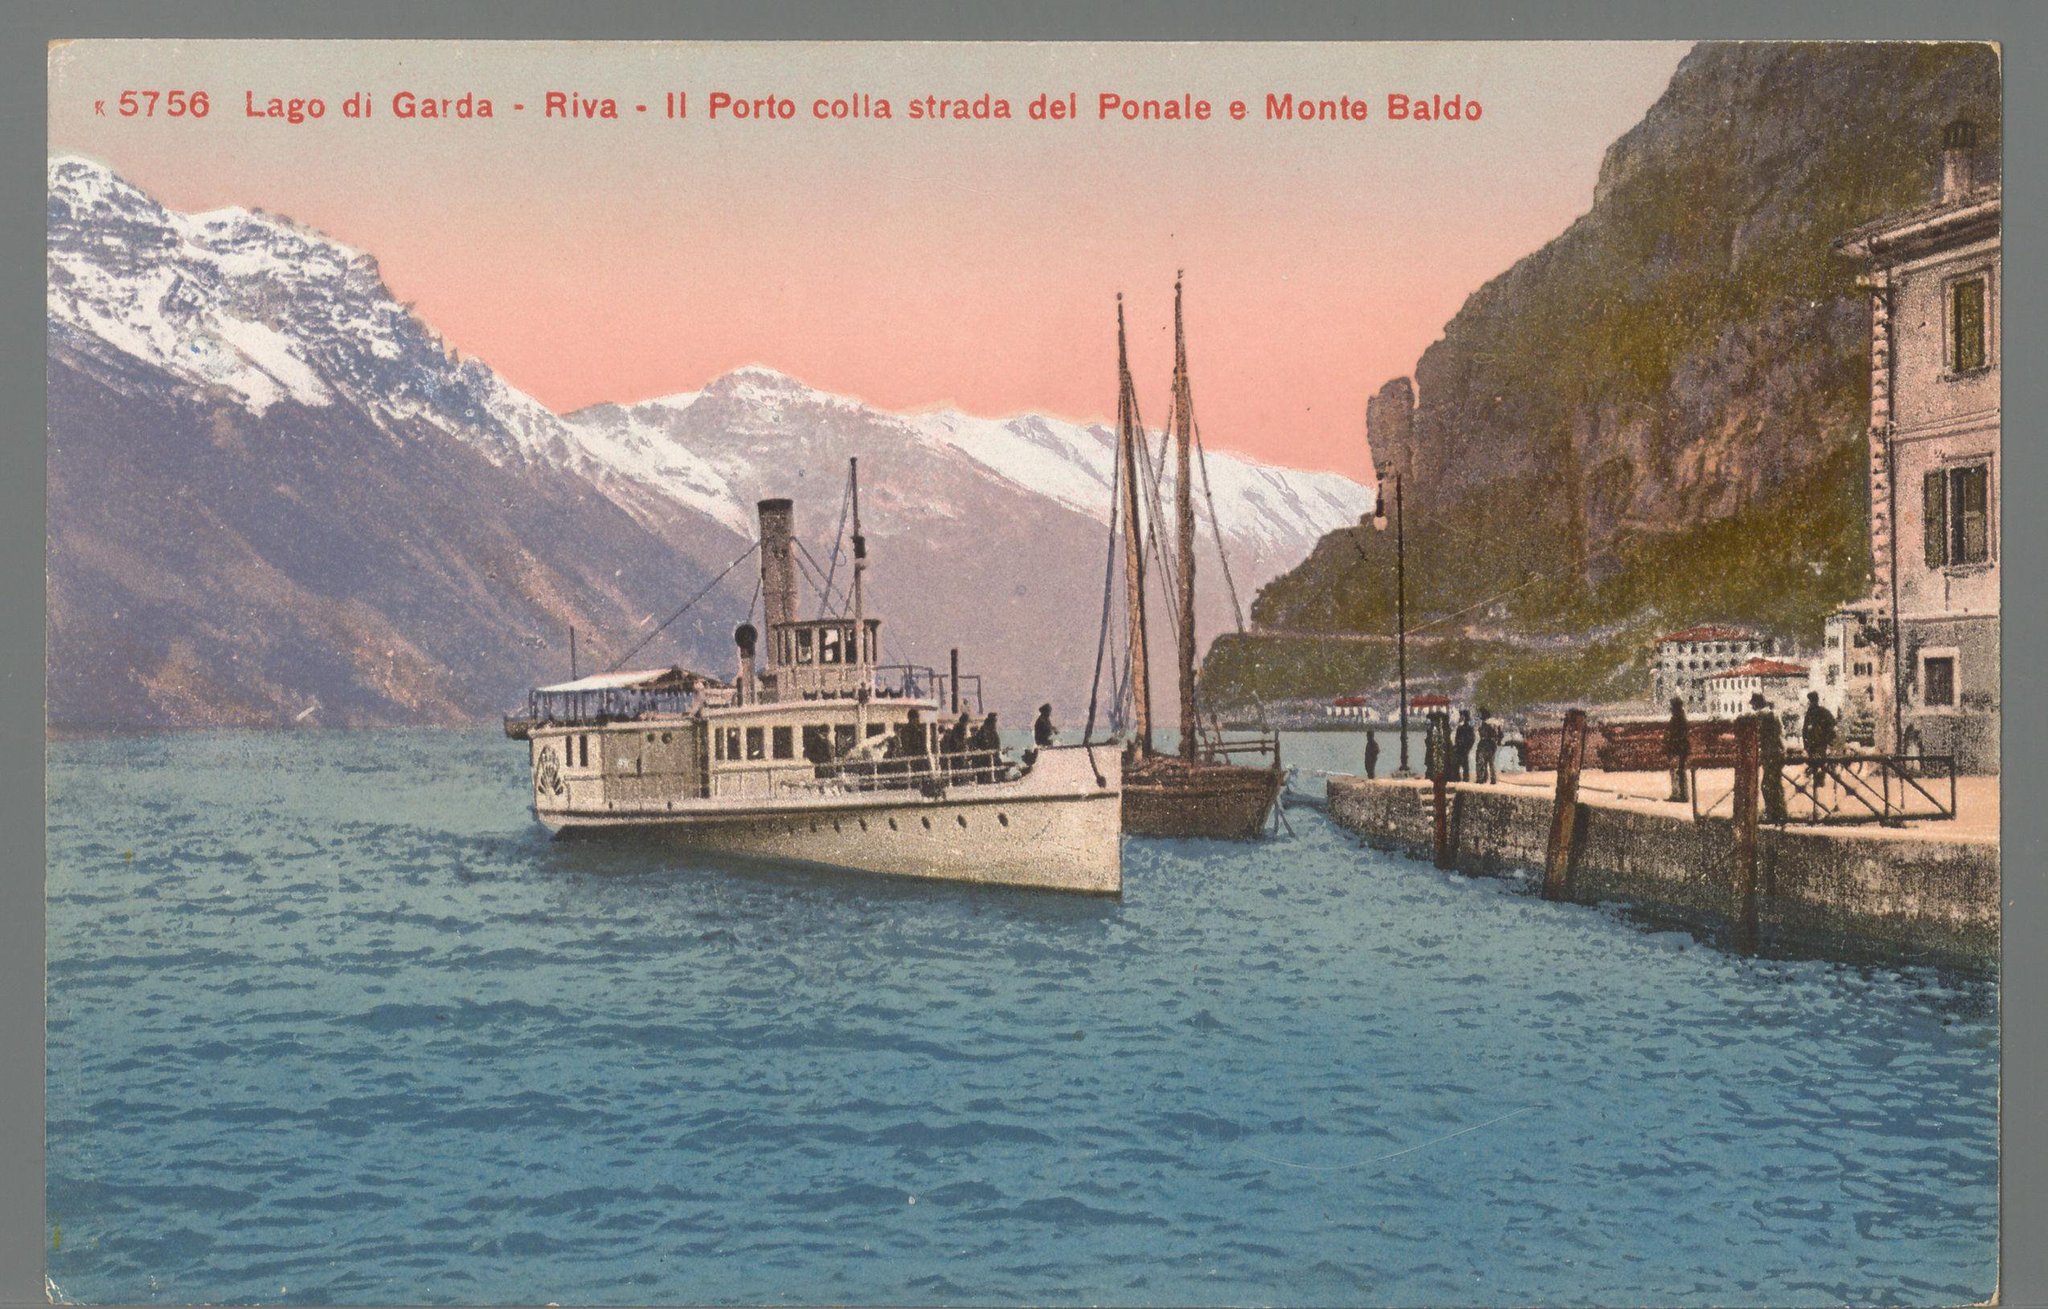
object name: ansichtkaart, prentbriefkaart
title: Lago di Garda. Riva. Il Porto colla strada del Ponale e Monte Baldo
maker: Anonymous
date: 1905-1930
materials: cardboard, photographic process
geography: zurich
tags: ships (in general), lake, mountains